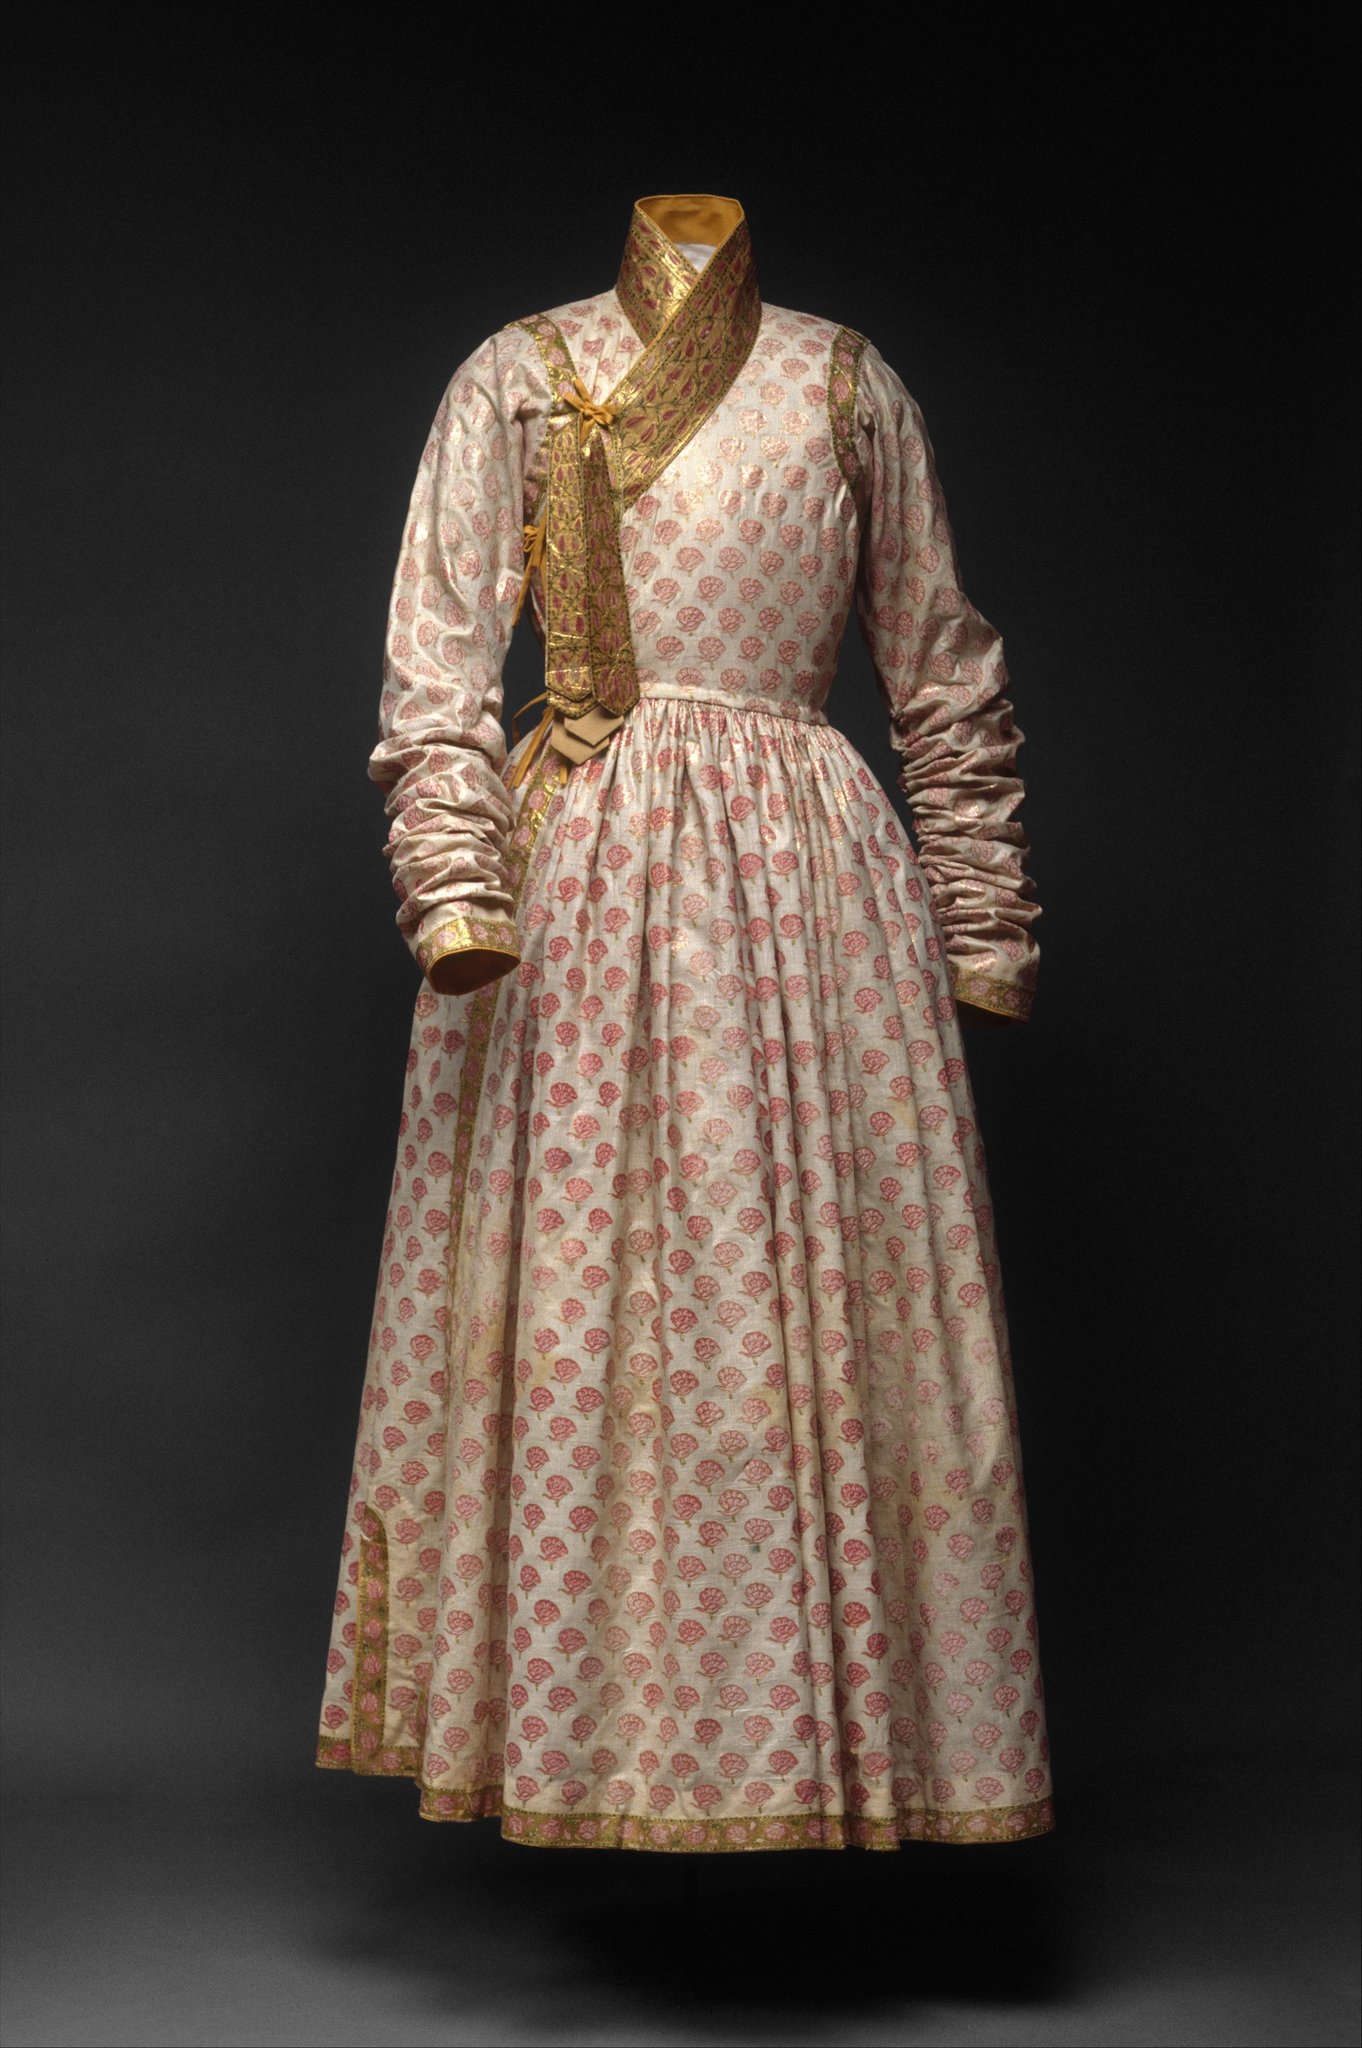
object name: robe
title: Man's Robe (Jama) with Poppies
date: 1601-1700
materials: cotton, gold leaf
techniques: painting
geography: india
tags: poppies